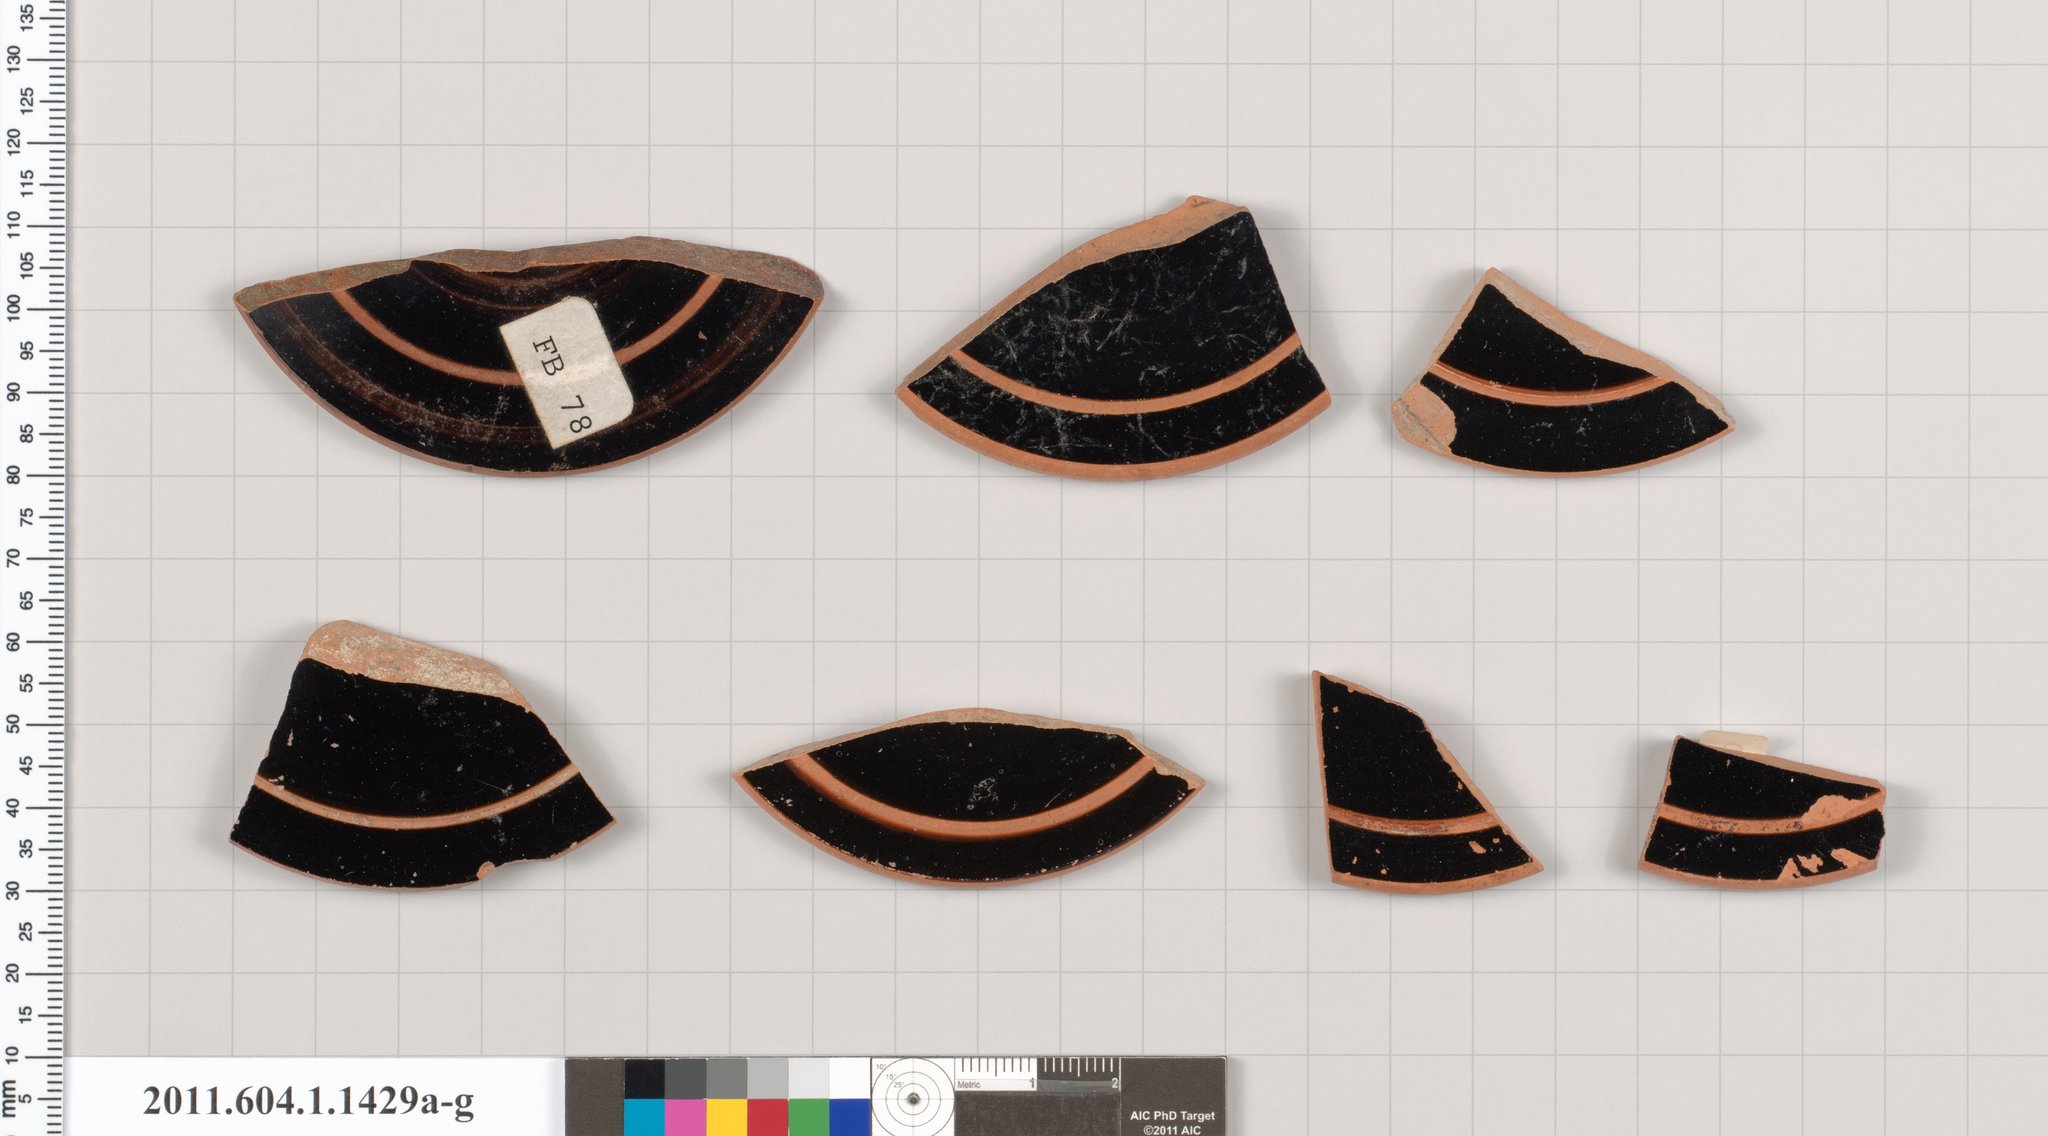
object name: kylix fragment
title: Terracotta fragments of kylikes (drinking cups)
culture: greek, attic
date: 500-401 BCE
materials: terracotta